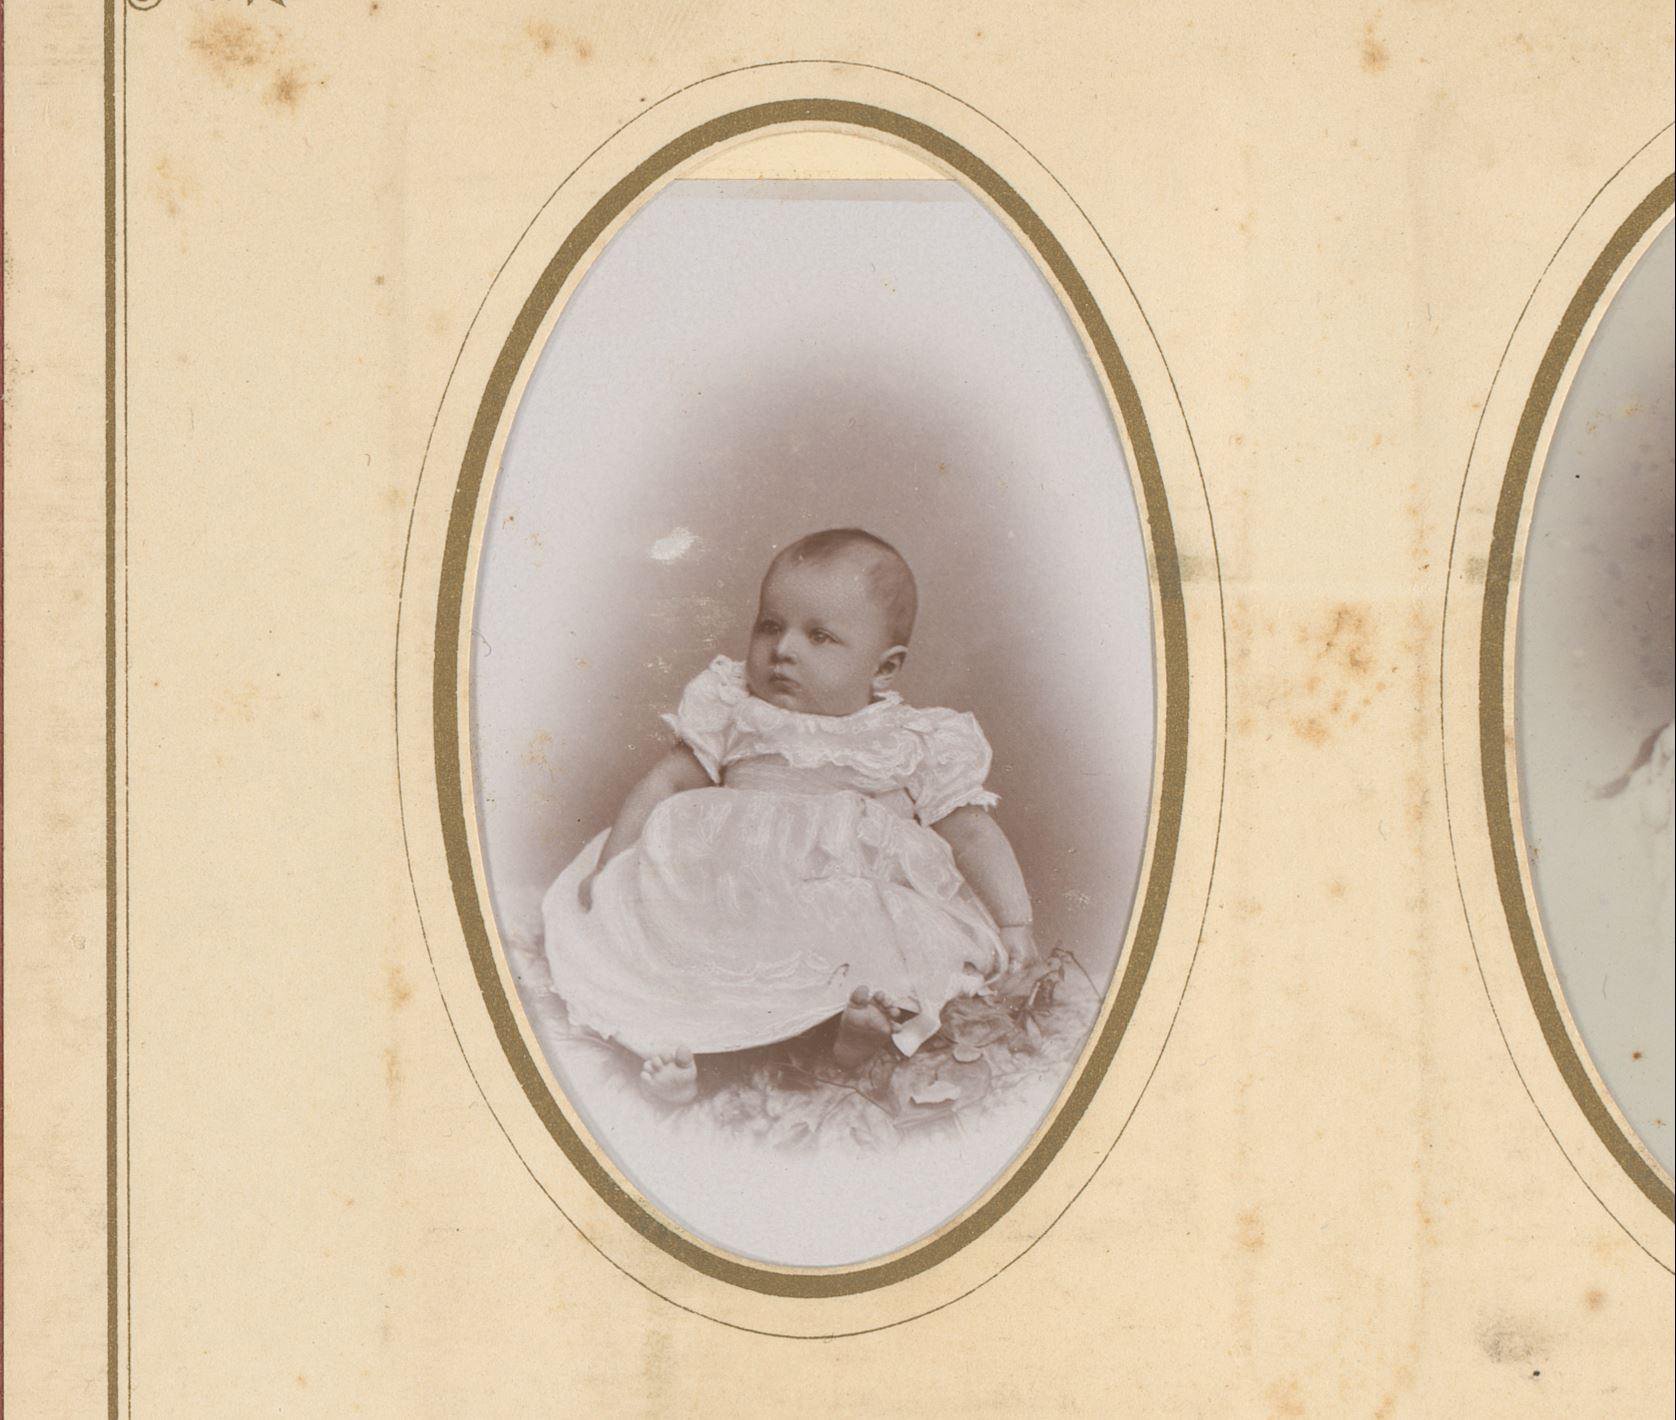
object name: photograph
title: Portret van een zittende baby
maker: jan kz de vries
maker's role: fotograaf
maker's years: 1857-1926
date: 1895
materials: cardboard, photographic support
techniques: collodion silver print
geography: assen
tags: sitting figure, historical persons, infant, baby ~ the ages of man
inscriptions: inscription: ‘Specialité/ de/ Photographie/ Artistique/ Jan de Vries Kzn./ Inrichting/ voor/ Vergrootingen/ in het/ Onveranderlijke/ Assen, Kloosterstraat./ Hoogeveen/ aan't schut./ Het cliché blyft bewaard.’, annotation: ‘[...] 1/2 jaar 26 Juni 95’